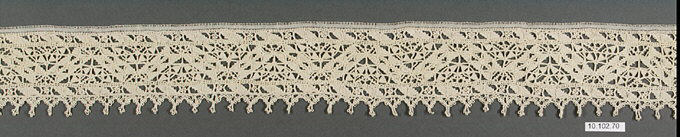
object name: fragment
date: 1501-1700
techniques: lace